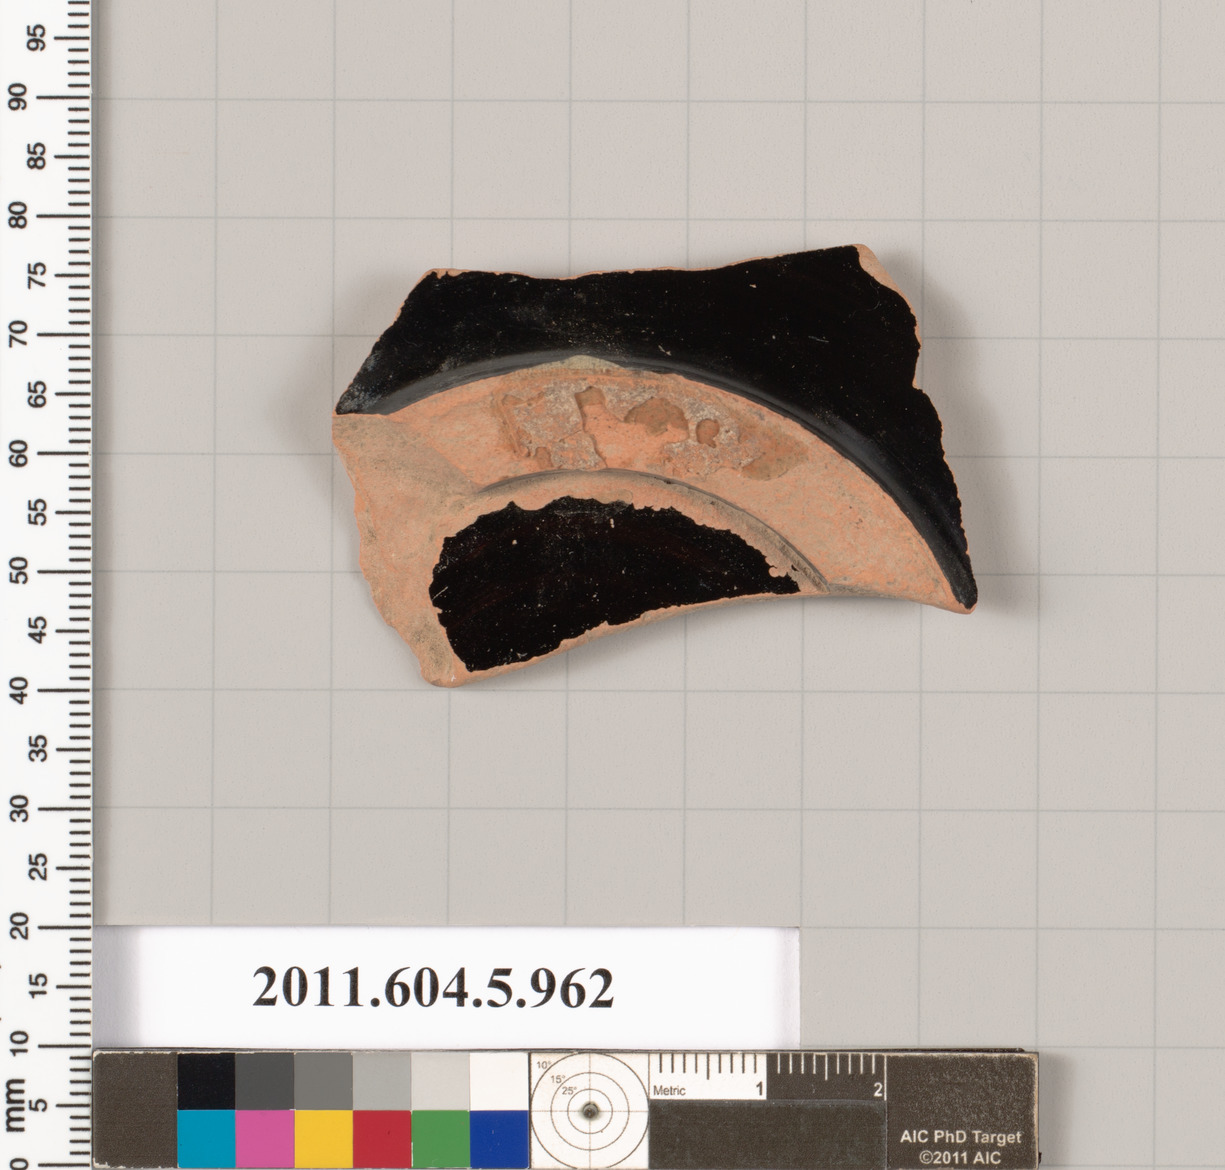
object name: kylix fragment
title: Terracotta fragment of a stemless kylix (drinking cup)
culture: greek, attic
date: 600-401 BCE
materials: terracotta